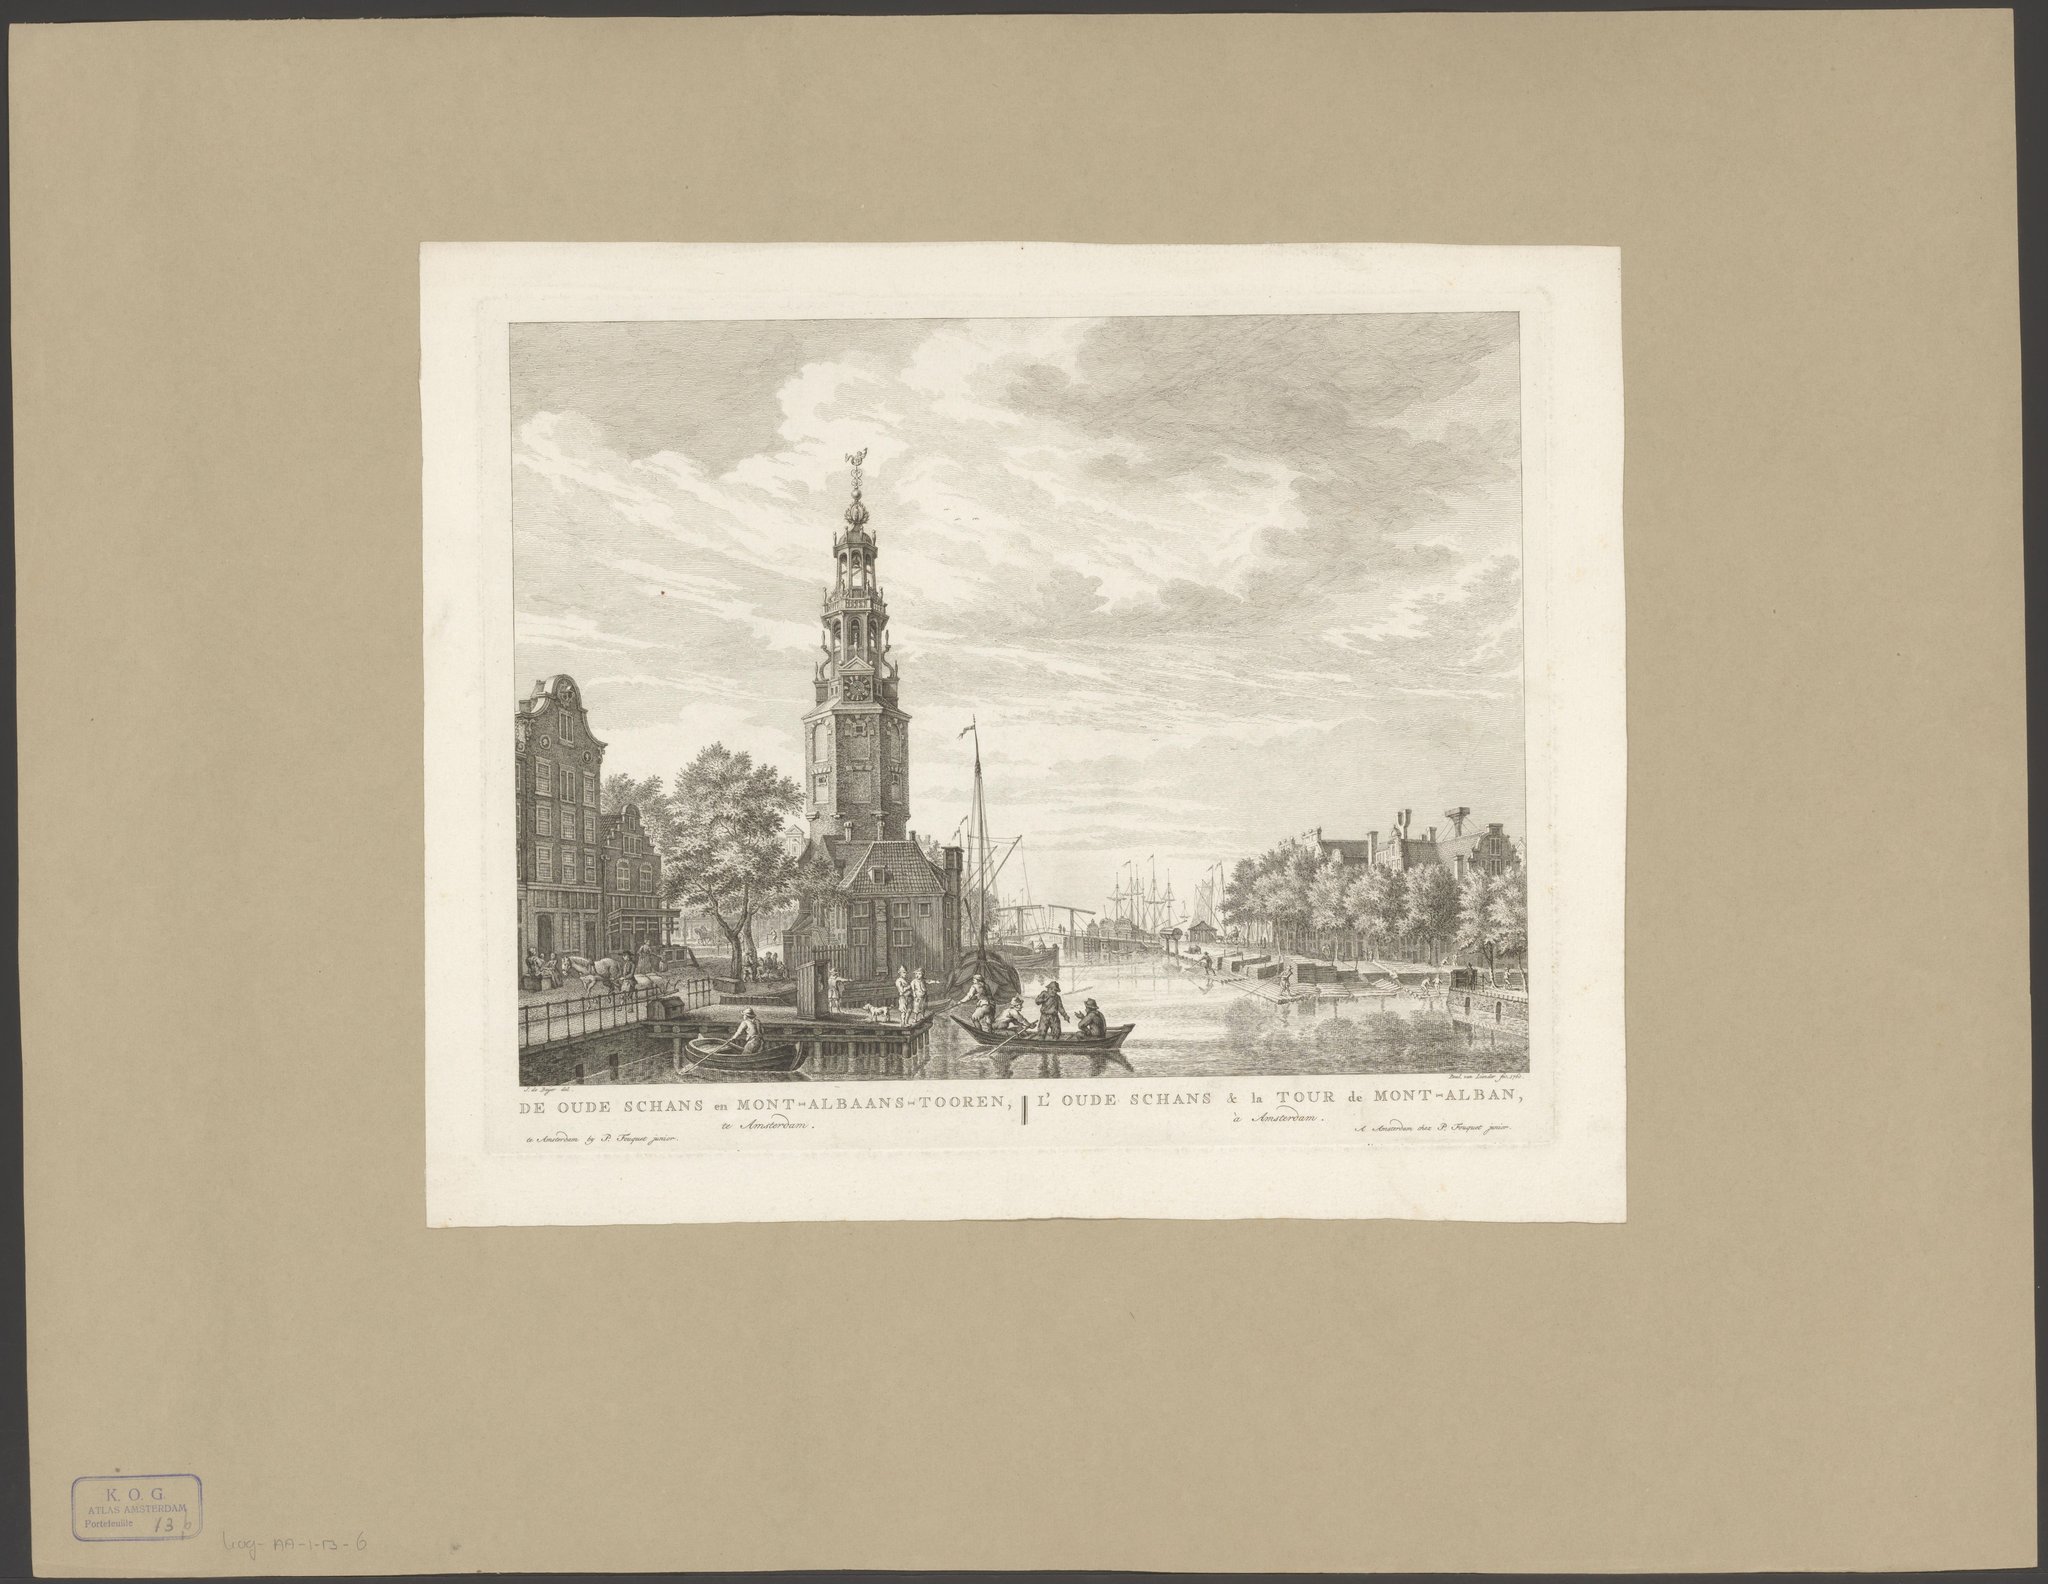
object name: print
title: De Oude Schans en Mont-Albaans-Tooren, te Amsterdam / L'Oude Schans & la Tour de Mont-Alban, à Amsterdam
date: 1760-1783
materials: paper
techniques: engraving, etching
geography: amsterdam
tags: tower, clock tower ~ monumental adornment, city-view in general; 'veduta', river, bridge in city across river, canal, etc., boat propelled by man or animal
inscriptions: collector's mark: ‘13,6’ Lugt 1641b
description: Deze prent is ook gebruikt in de zogenaamde Atlas van Fouquet.* Pierre Fouquet gaf vanaf 1760 stadsgezichten van Amsterdam - naar tekeningen van verschillende kunstenaars, gemaakt door verschillende prentmakers - uit. Deze prenten werden aanvankelijk los of in series verkocht. Zoals toen gebruikelijk kon de koper de prenten zelf laten inbinden. Hiertoe gaf Fouquet tussen 1778 en 1783 een titelblad, plattegrond en inhoudsopgave van de tot dusver 100 uitgegeven prenten uit (1). Gezien de inhoud afhankelijk was van wat de koper had verzameld verschilt de inhoud van de verschillende bewaarde Fouquetatlassen onder deze titel sterk. Ook zijn er exemplaren bekend waar tevens andere prenten aan zijn toegevoegd. Omdat er behoefte bleek aan uitleg bij de platen werd in 1783 een nieuwe versie van de atlas uitgegeven, aangevuld met tekst en twee prenten. De aangegeven volgorde veranderde maar de platen van de al eerder uitgegeven prenten bleven ongewijzigd. Deze uitgave werd in opdracht van Fouquet gedrukt bij Daniël Jean Changuion en Petrus den Hengst (2). Een tiental platen werd bijgewerkt en verscheen, met nieuw impressum, in het vervolg van Wagenaars geschiedenis van Amsterdam, uitgeven door Petrus Conradi en Folkert van der Plaats (3). Een aantal jaar na het overlijden van Fouquet kwam Evert Maaskamp met een nieuwe uitgave van de atlas, met verbeterde tekst en toevoeging van twee prenten. Op alle platen verwijderde hij het oude en liet hij zijn eigen impressum zetten (4). De huidige staat van de prent komt voor in exemplaren van de onder (1) en (2) genoemde werken. * Onder de Atlas van Fouquet of Fouquetatlas verstaan we de hieronder vermelde publicaties (1), (2) en (4). (1). Afbeeldingen van de wyd-vermaarde koopstad Amsterdam benevens des zelvs voornaamste gebouwen en gezigten alle naar het leeven getekend / Receuil des edifices les plus considerables et des plus belles vues, de la fameuse ville d'Amsterdam, dessinées d'après nature. Amsterdam: Pierre Fouquet, 1778-1783. (2). Nieuwe atlas, van de voornaamste gebouwen en gezigten der stad Amsterdam, met derzelver beknopte beschryvingen. 2 delen. Amsterdam: Daniël Jean Changuion en Petrus den Hengst [in opdracht van Pierre Fouquet], 1783. (3). Stijl, Simon. Amsterdam, in zyne geschiedenissen, voorregten, koophandel, gebouwen, kerkenstaat, schoolen, schutterye, gilden en regeeringe, beschreeven. Om te dienen ten vervolge op het werk van Jan Wagenaar (…). 10 delen. Amsterdam en Harlingen: Petrus Conradi en Folkert van der Plaats, 1788-1801. (4). Nieuwe atlas, van de voornaamste gebouwen en gezigten der stad Amsterdam. Met derzelver beknopte beschryvingen. Amsterdam: Evert Maaskamp, 1805. * Het aantal vermelde staten is gebaseerd op het aantal gevonden staten. Mogelijk zijn er meer staten van deze prent. Vermoedelijke eerste staat in collectie van TU Delft met Paulus van Liender vermeld als prentmaker. Vermoedelijke derde staat, zie KOG-AA-1-13-5. Vermoedelijke vierde staat, zie RP-P-1905-399. Vermoedelijke vijfde staat, zie KOG-AA-1-29-68. Vermoedelijke laatste staat met adres van Maaskamp.